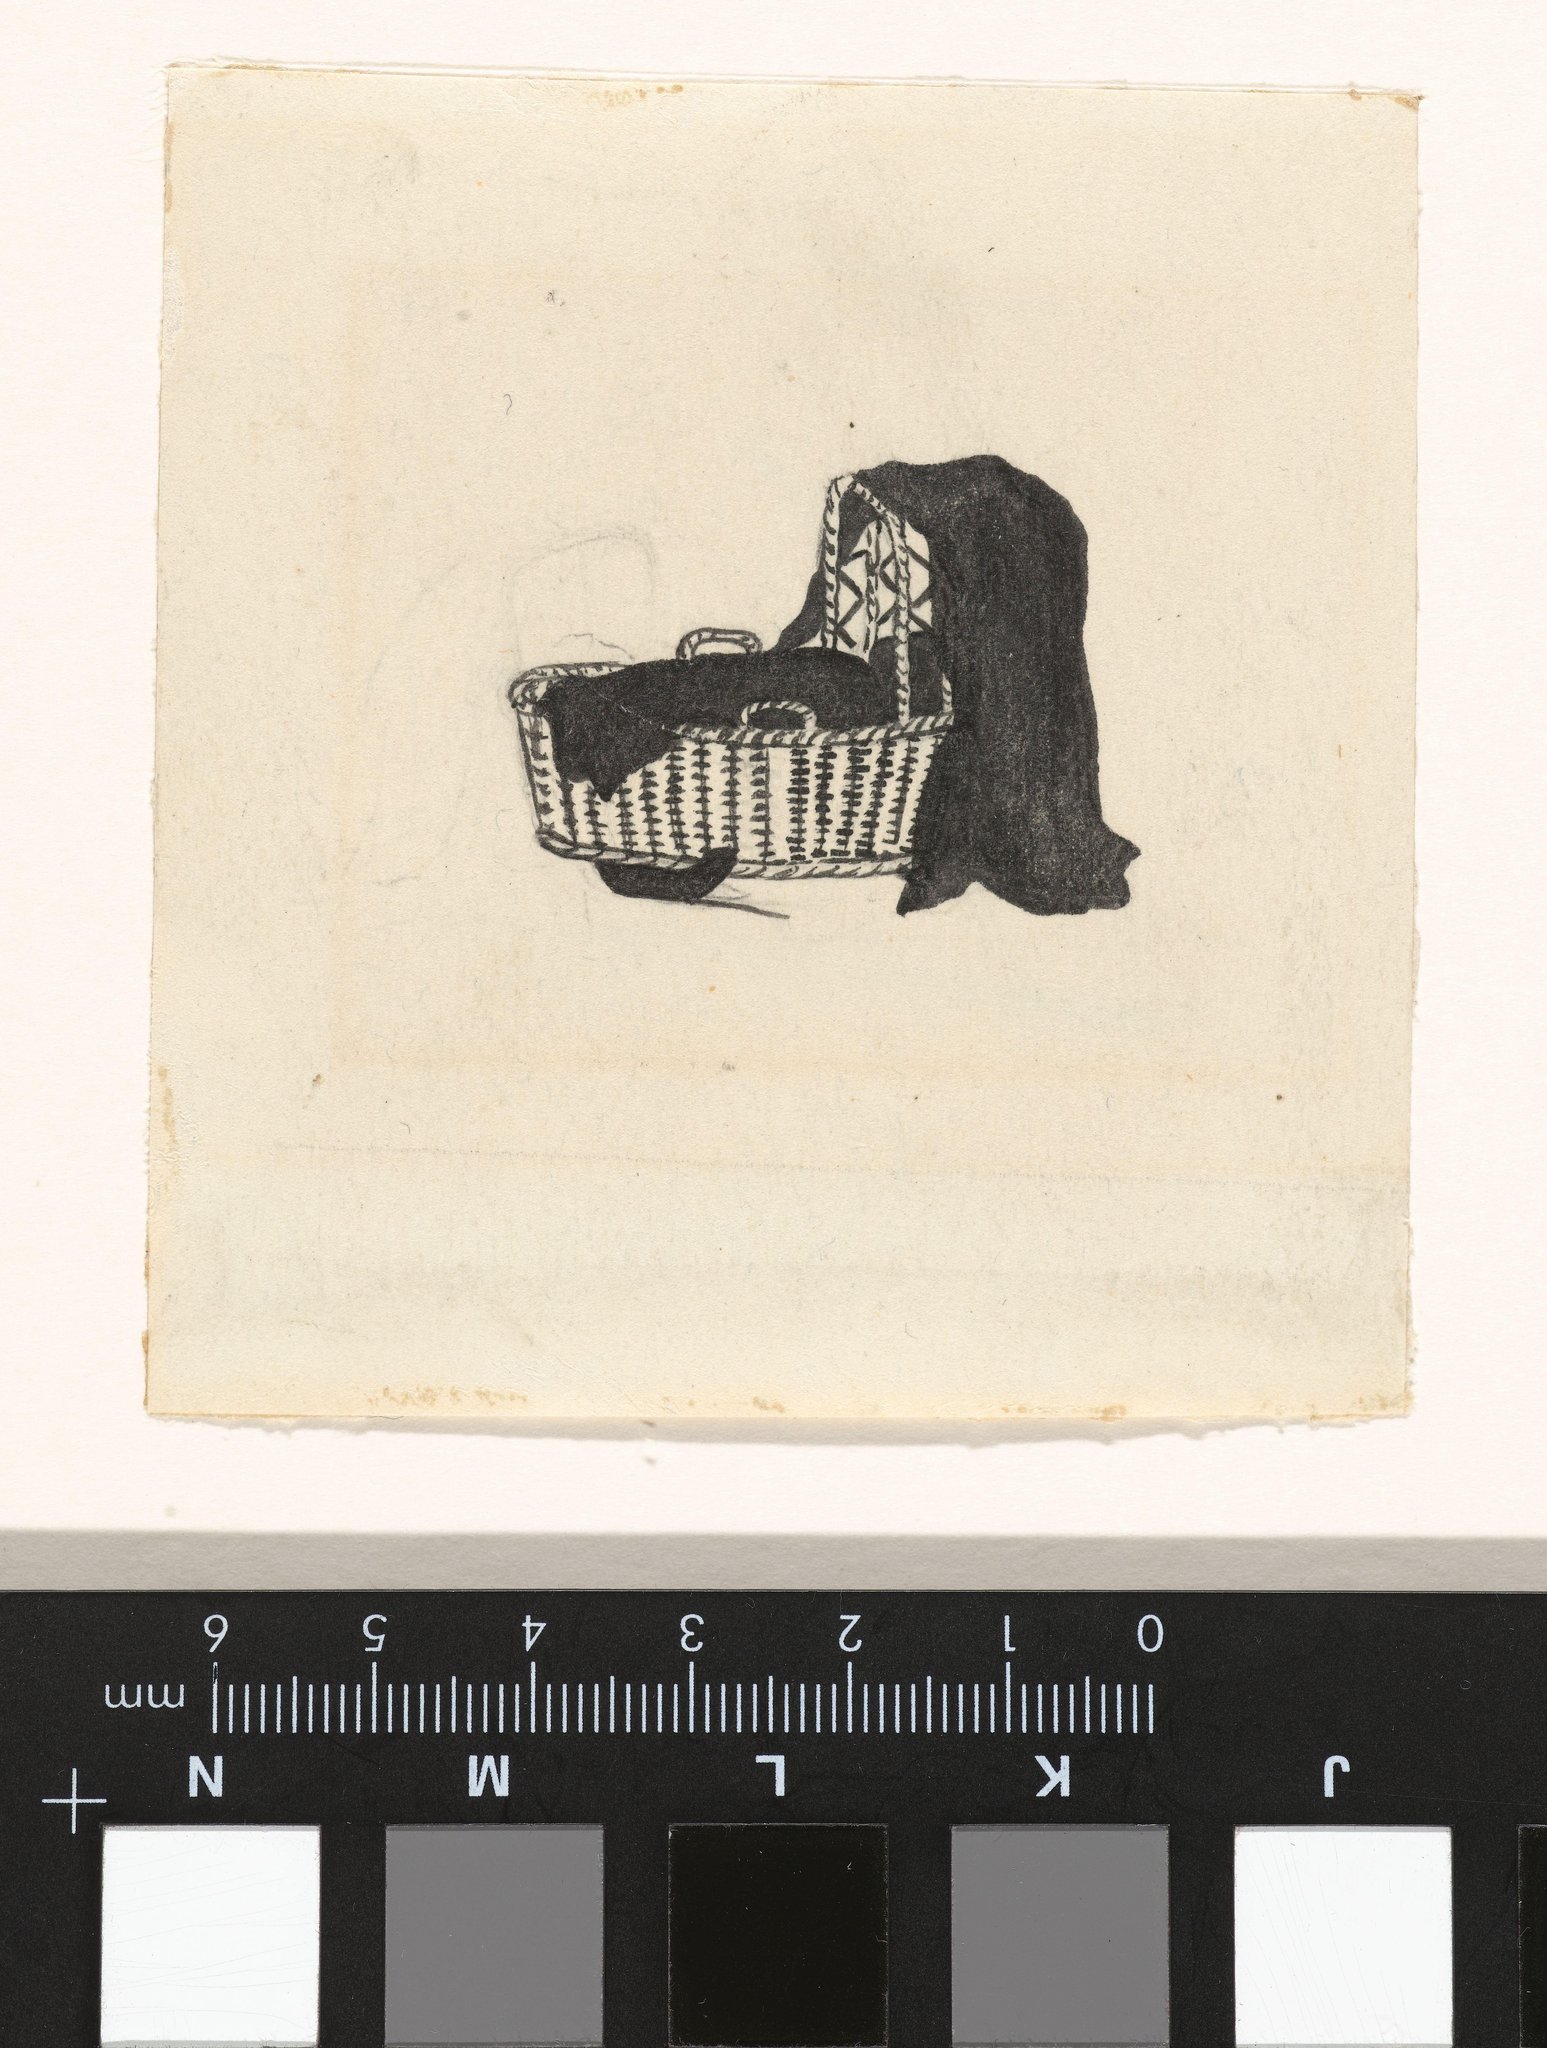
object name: drawing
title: Ontwerp voor In Holland staat een Huis: silhouet van een wieg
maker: nelly bodenheim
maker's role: designer, draughtsman, print maker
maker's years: 1874-1951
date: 1884-1917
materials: paper, pencil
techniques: brush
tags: 83(van looy, in holland staat een huis)